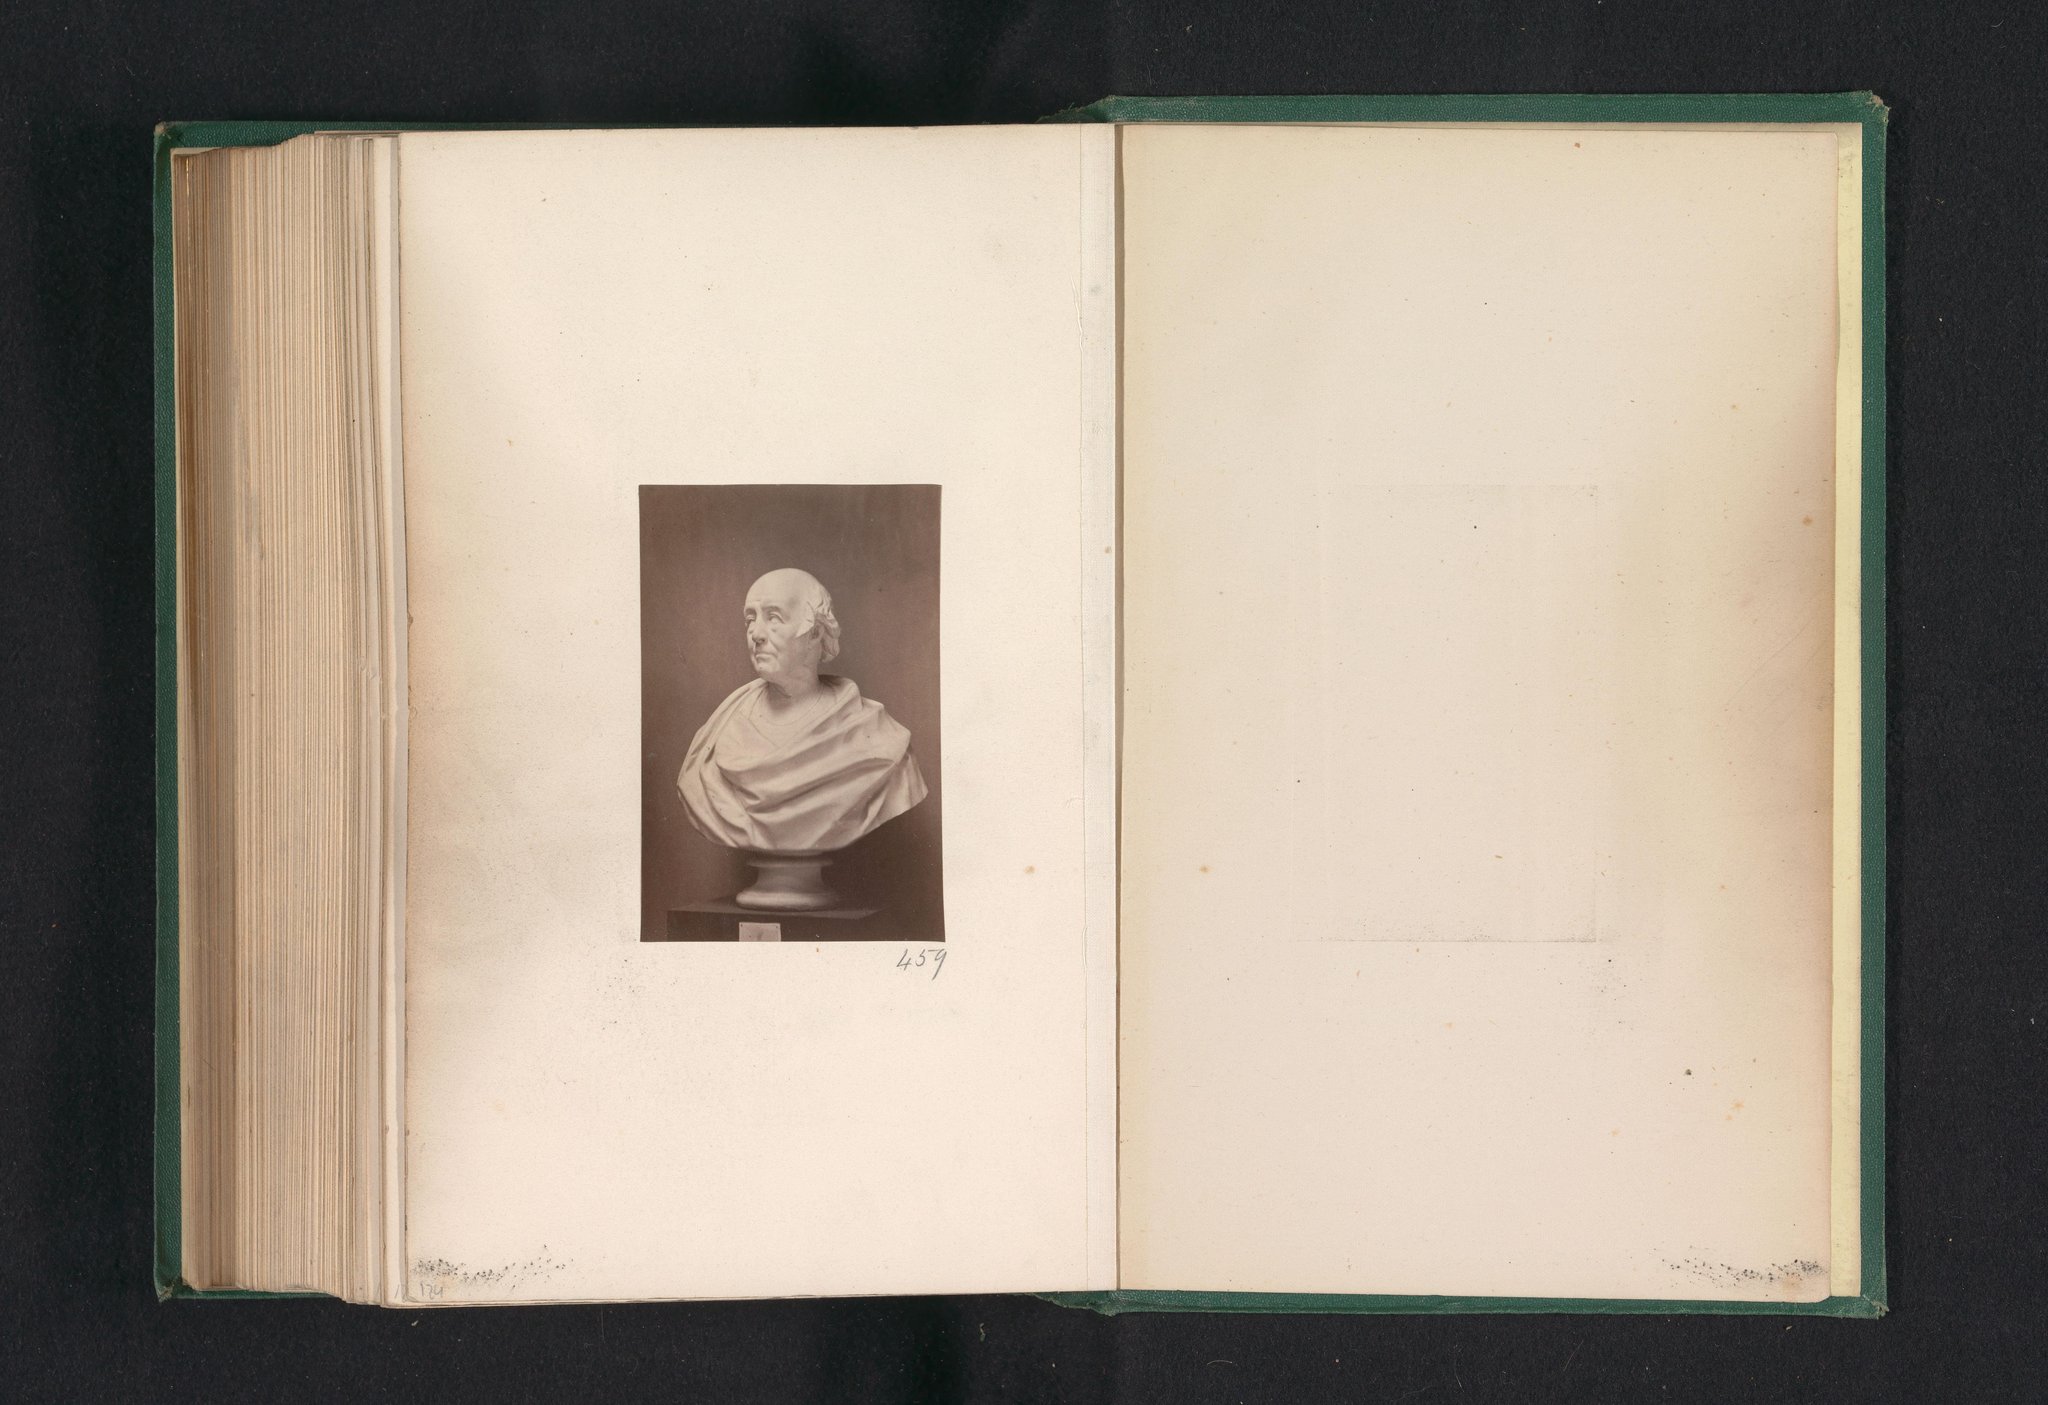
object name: photograph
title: Buste van Robert Wallace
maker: thomas annan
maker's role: fotograaf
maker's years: 1829-1887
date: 1863-1868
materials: photographic support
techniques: albumen print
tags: historical persons (portraits and scenes from the life) (+ (full) bust portrait), sculpture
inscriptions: number: ‘459’